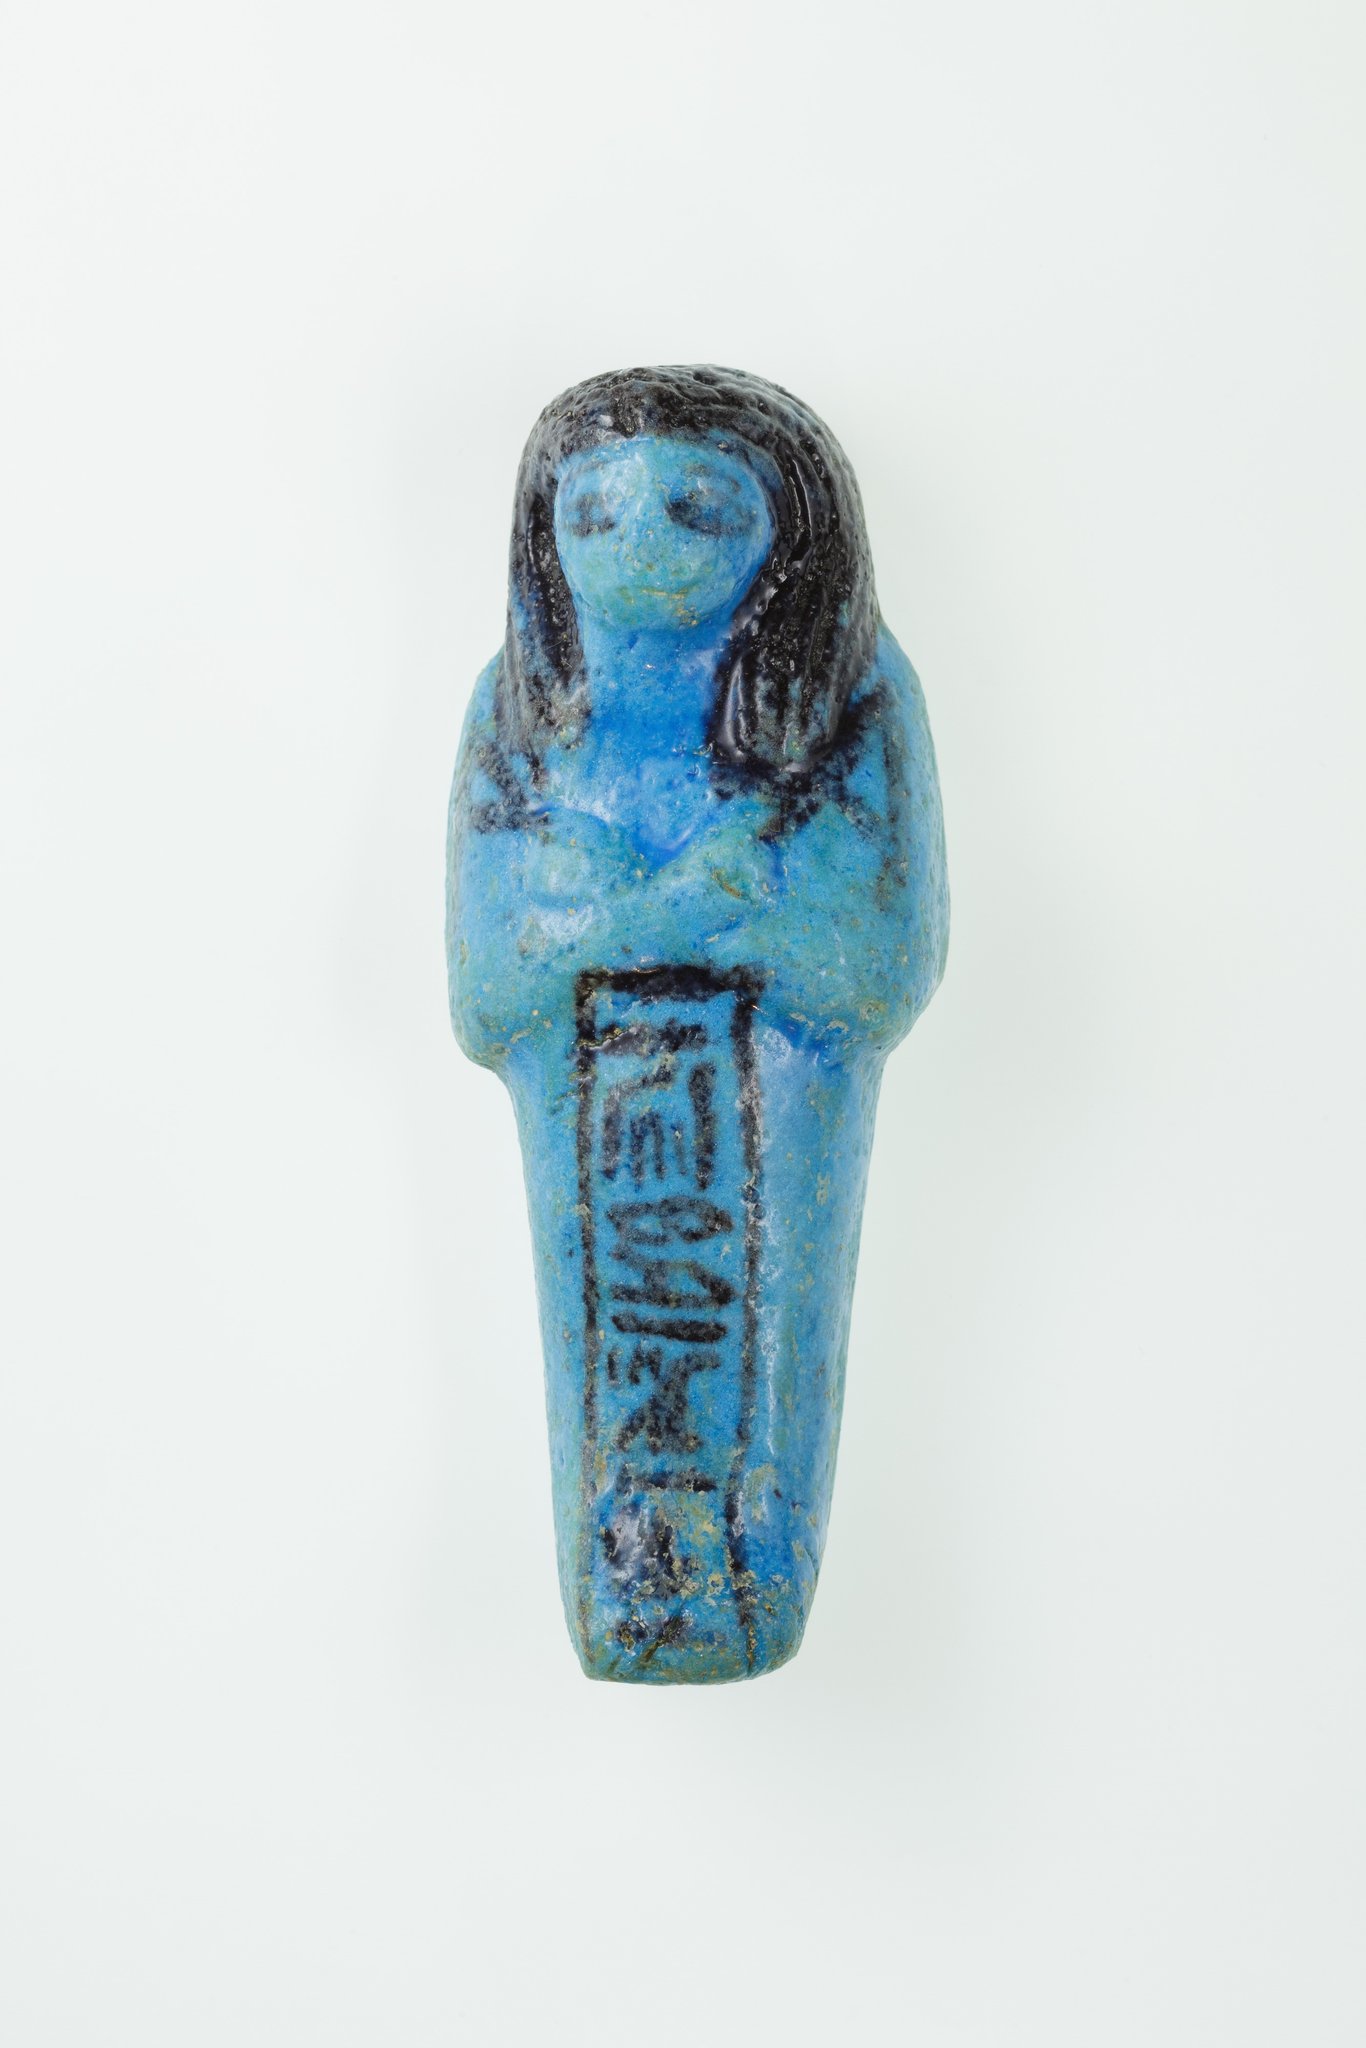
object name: shabti, worker, nauny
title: Worker Shabti of Nauny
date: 1050 BCE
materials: faience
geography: egypt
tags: hieroglyphs